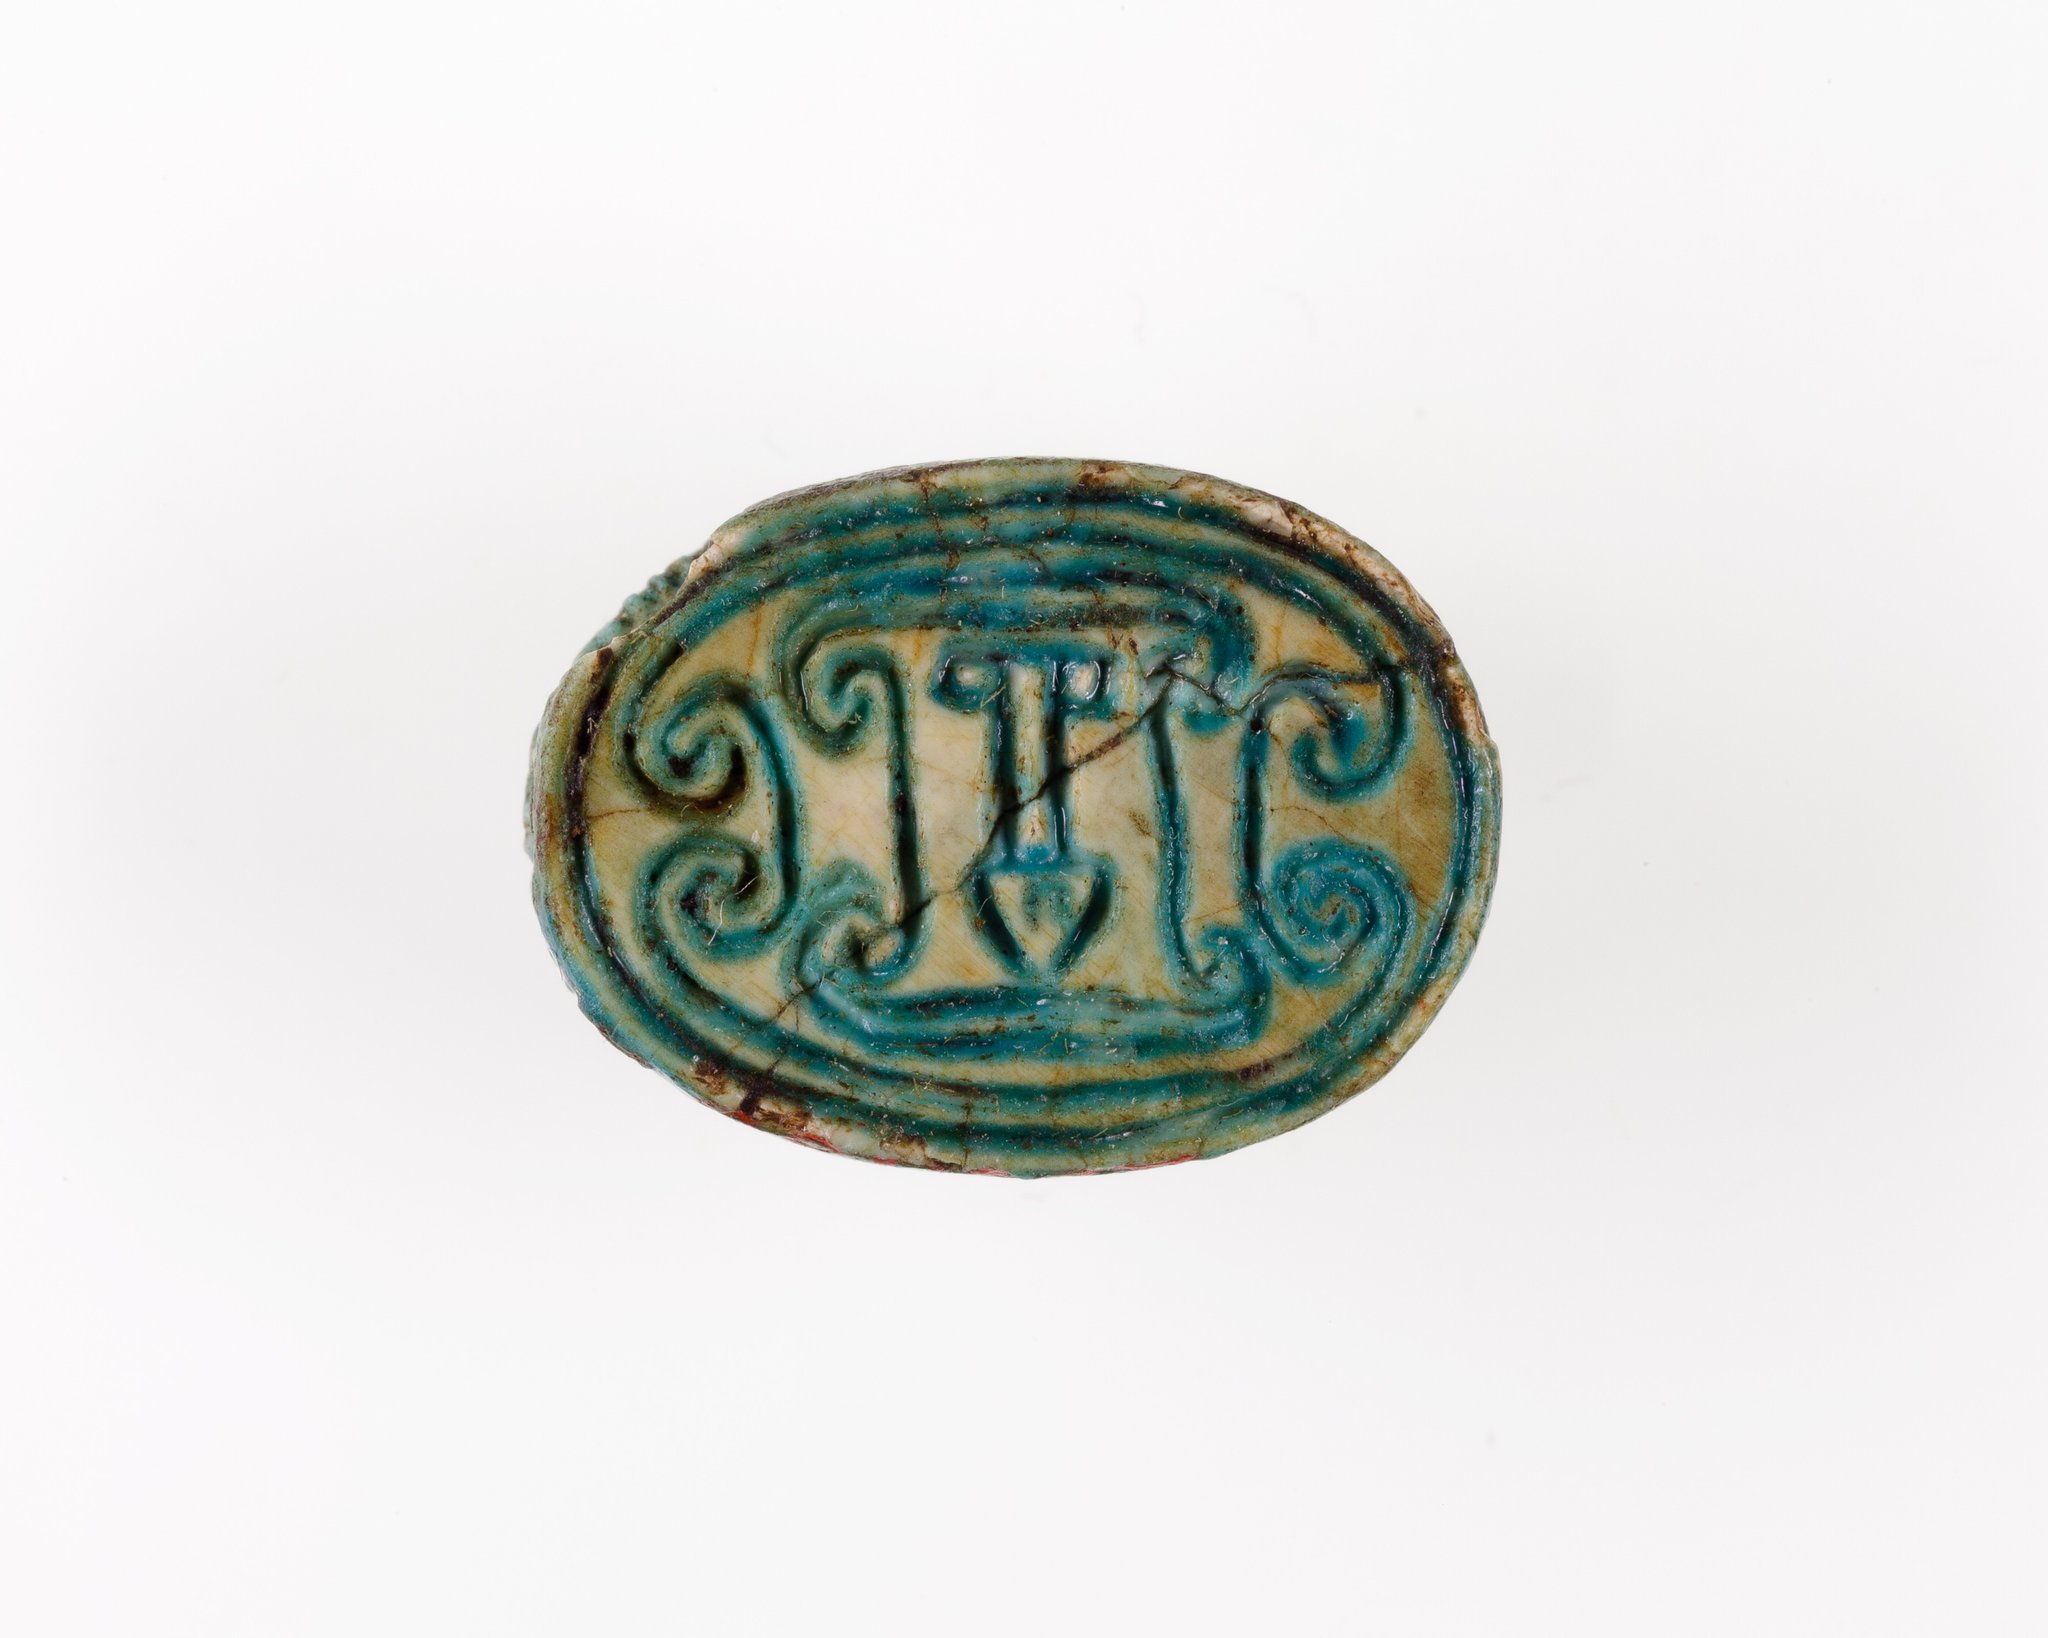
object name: scarab, nefer, scroll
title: Scarab Incised with Nefer Sign and Scrolls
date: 1760-1670 BCE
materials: stone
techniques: glazing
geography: egypt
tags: scarabs